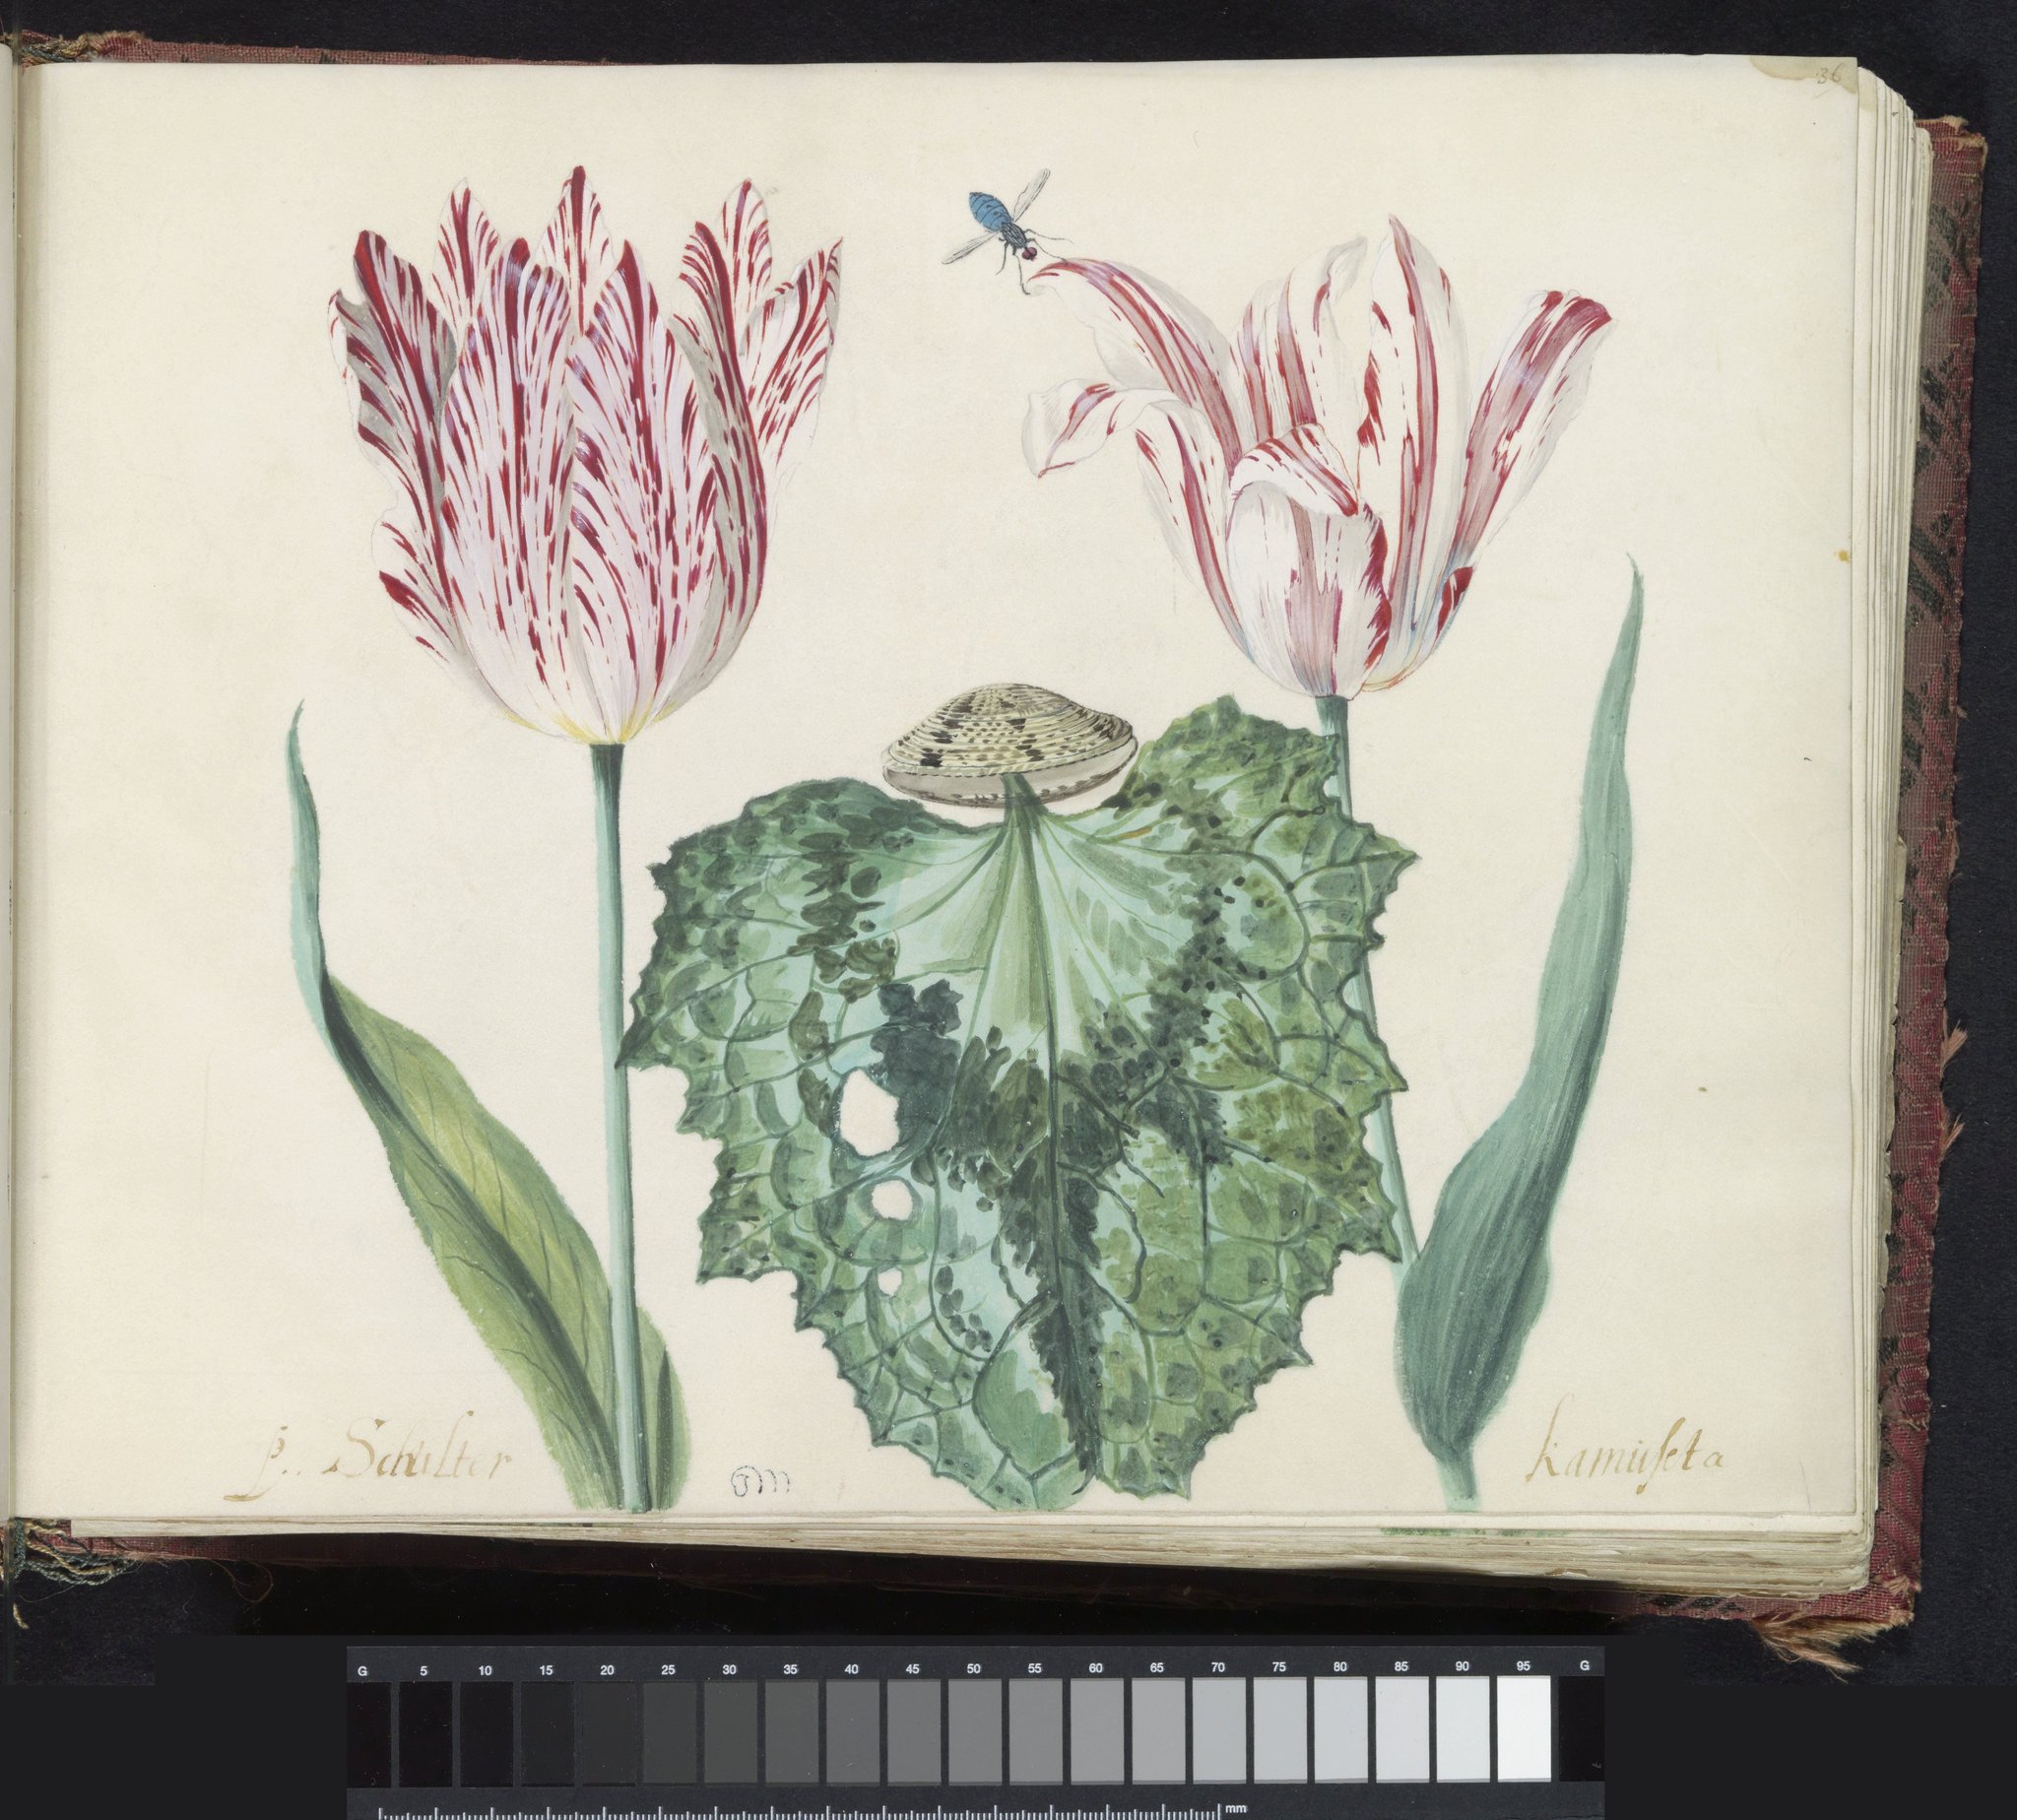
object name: album leaf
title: P. Schilter / Kamuseta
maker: jacob marrel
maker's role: draughtsman, painter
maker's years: 1614-1681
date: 1639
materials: paint, parchment, pencil, watercolor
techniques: brush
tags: flowers: tulip, molluscs (+ shell, snail-shell etc.), insects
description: De tekening maakt deel uit van een album.